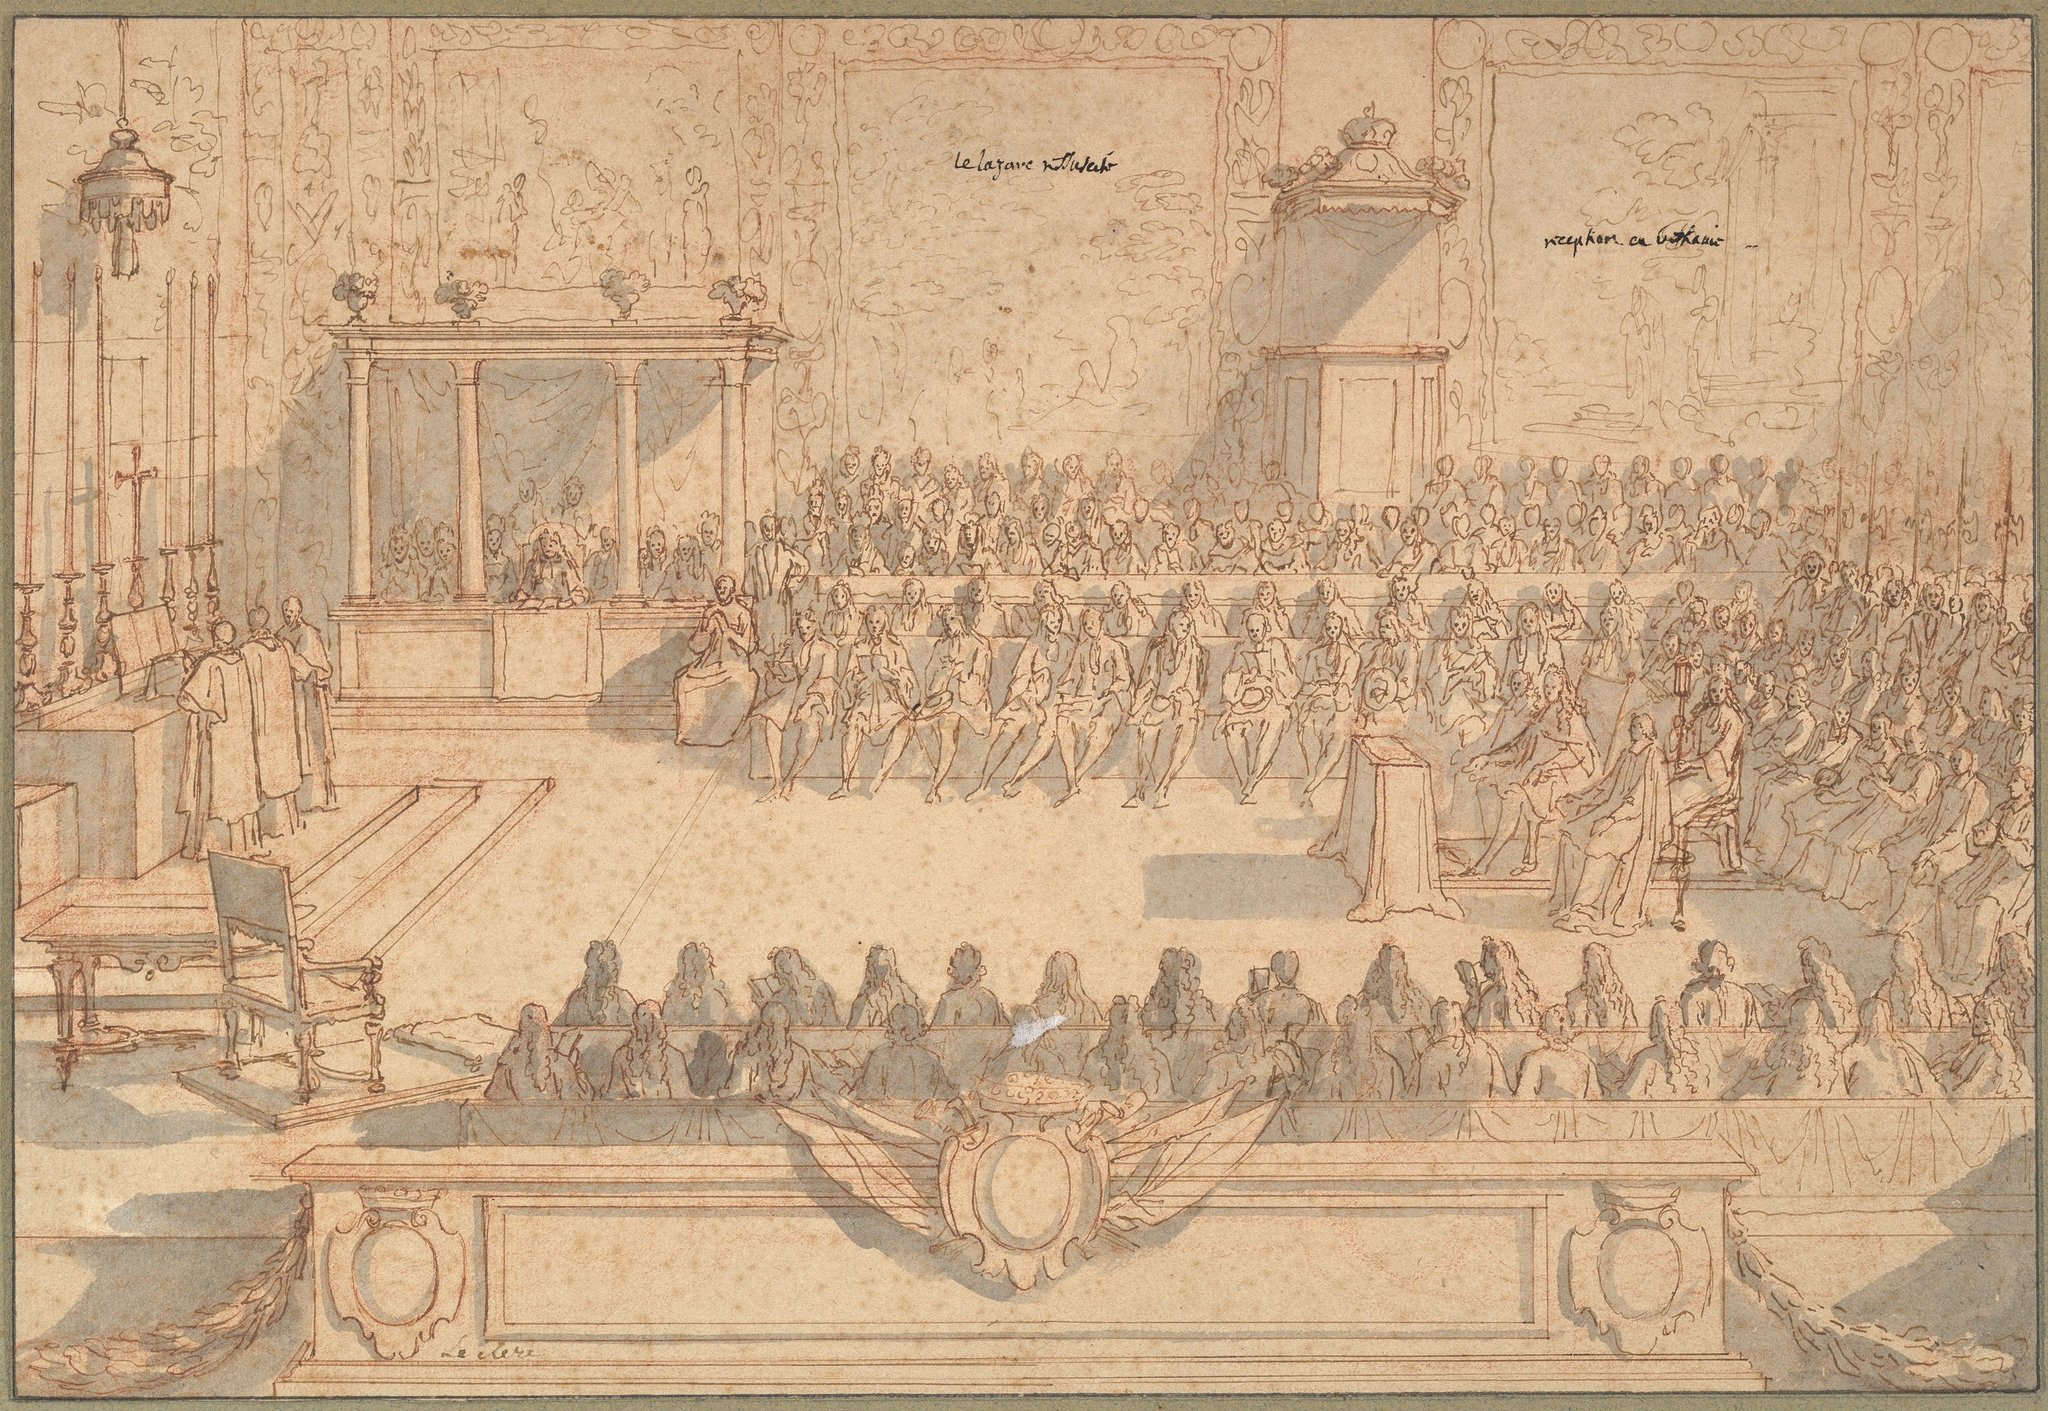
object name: drawing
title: A Gathering in a Church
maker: sébastien leclerc (i)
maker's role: artist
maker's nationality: french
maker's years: 1637-1714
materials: chalk, ink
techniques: brush, pen, wash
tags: churches,crowd,praying